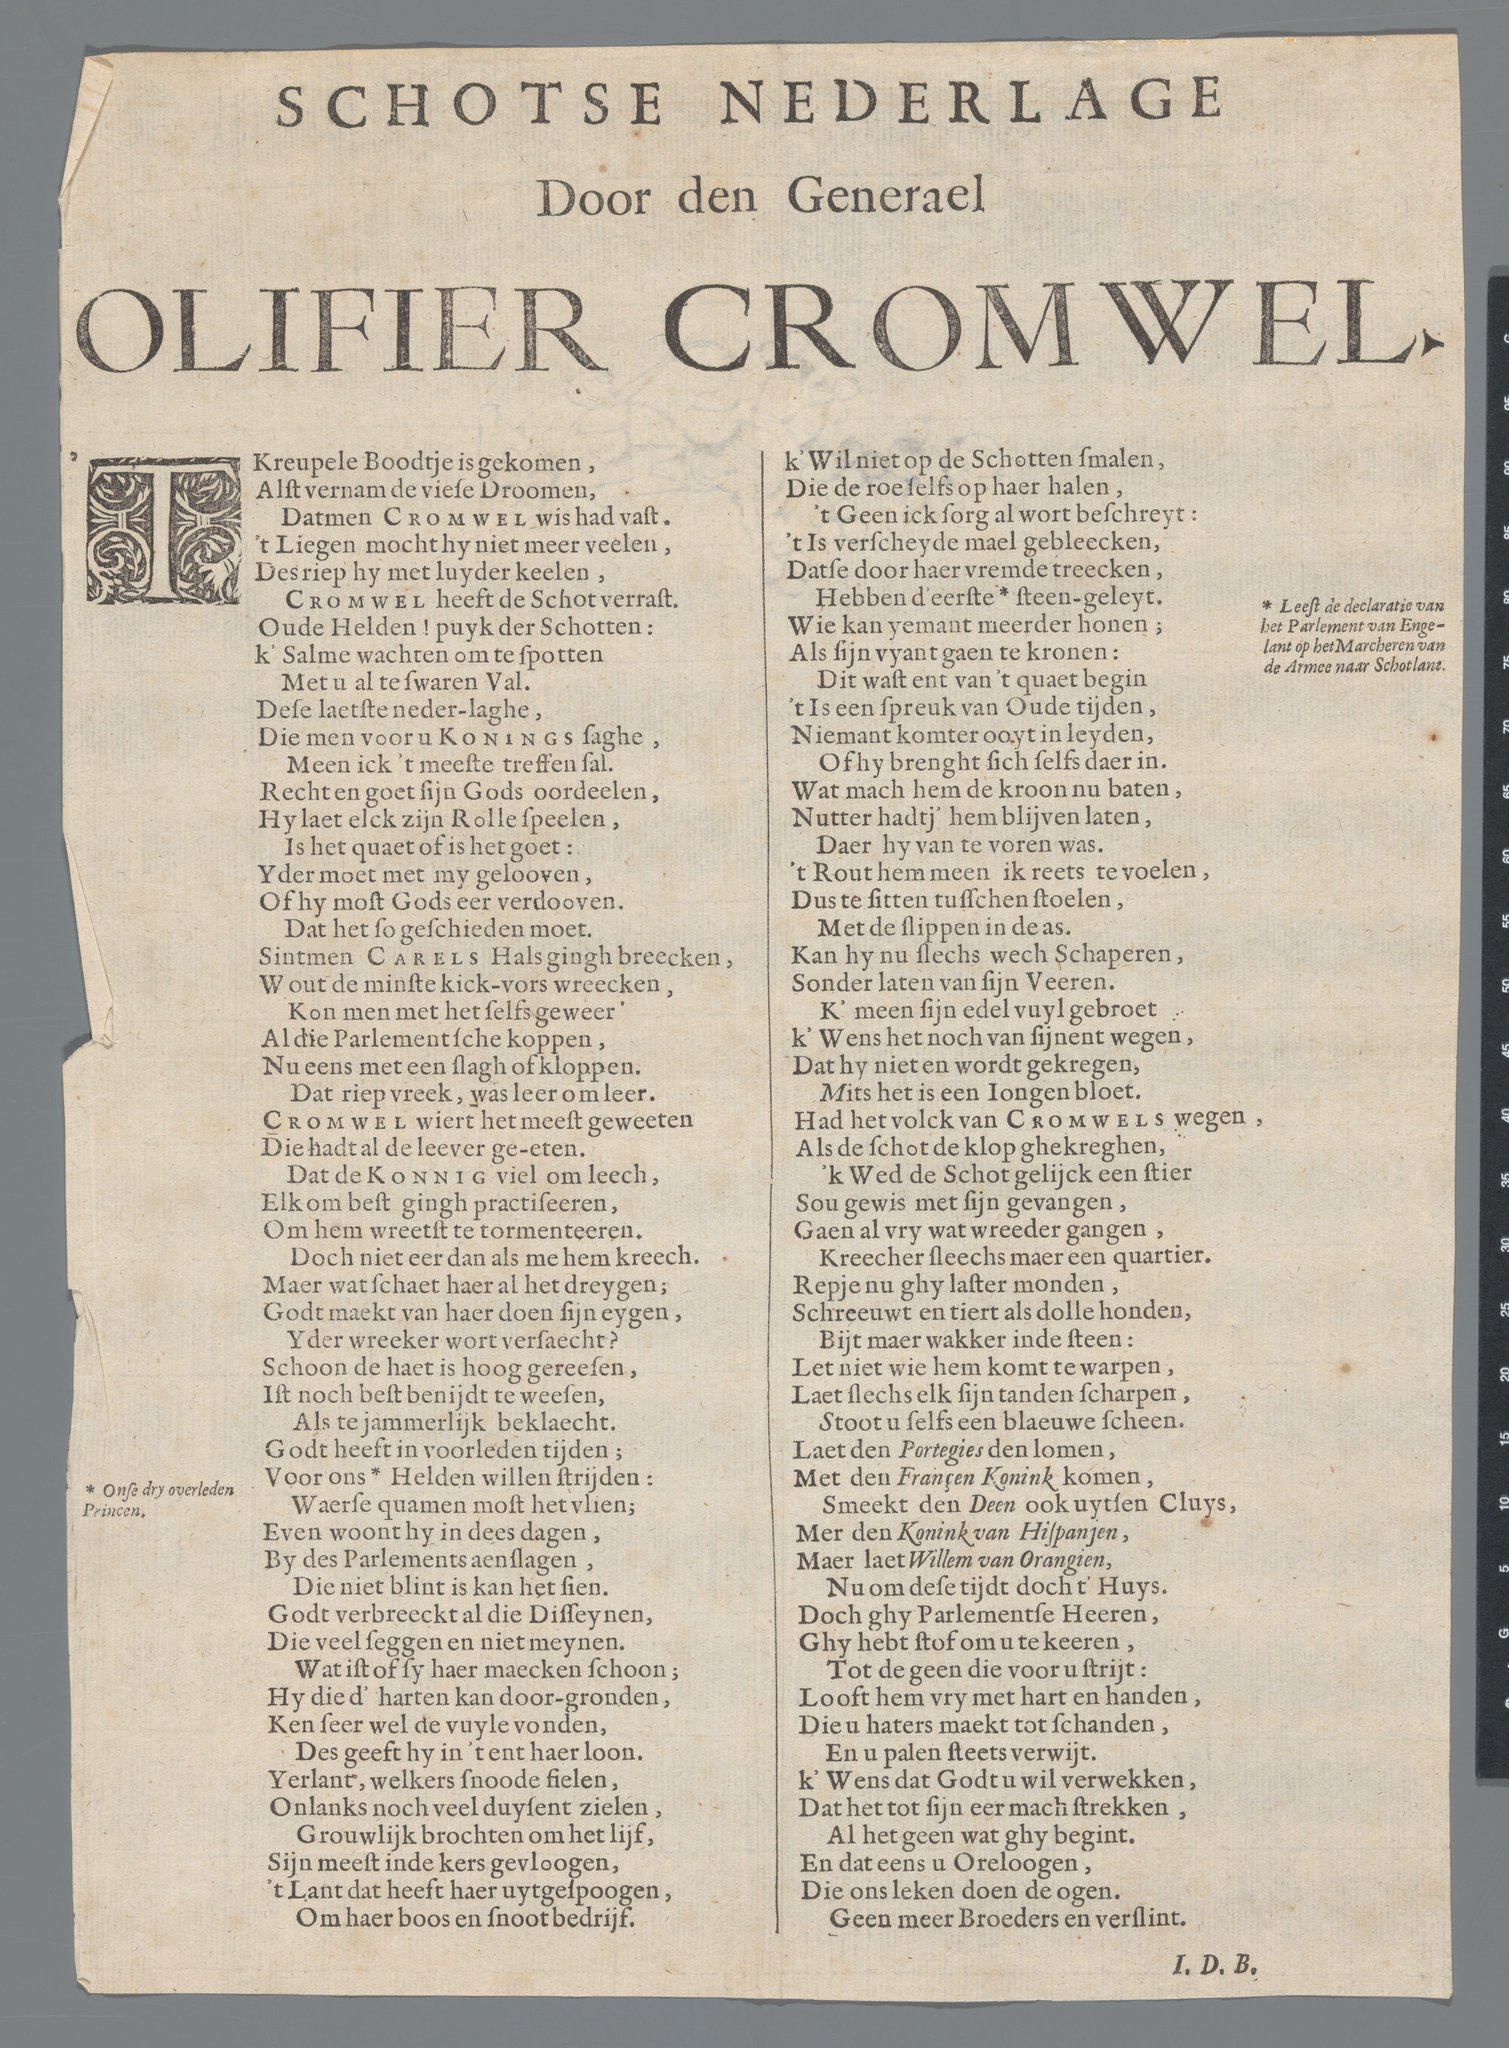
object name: pamphlet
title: Schotse Nederlage Door den Generael Olifier Cromwel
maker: monogrammist idb (schrijver)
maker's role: schrijver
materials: paper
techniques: printing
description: Eénzijdig bedrukt vel met gedicht in twee kolommen.